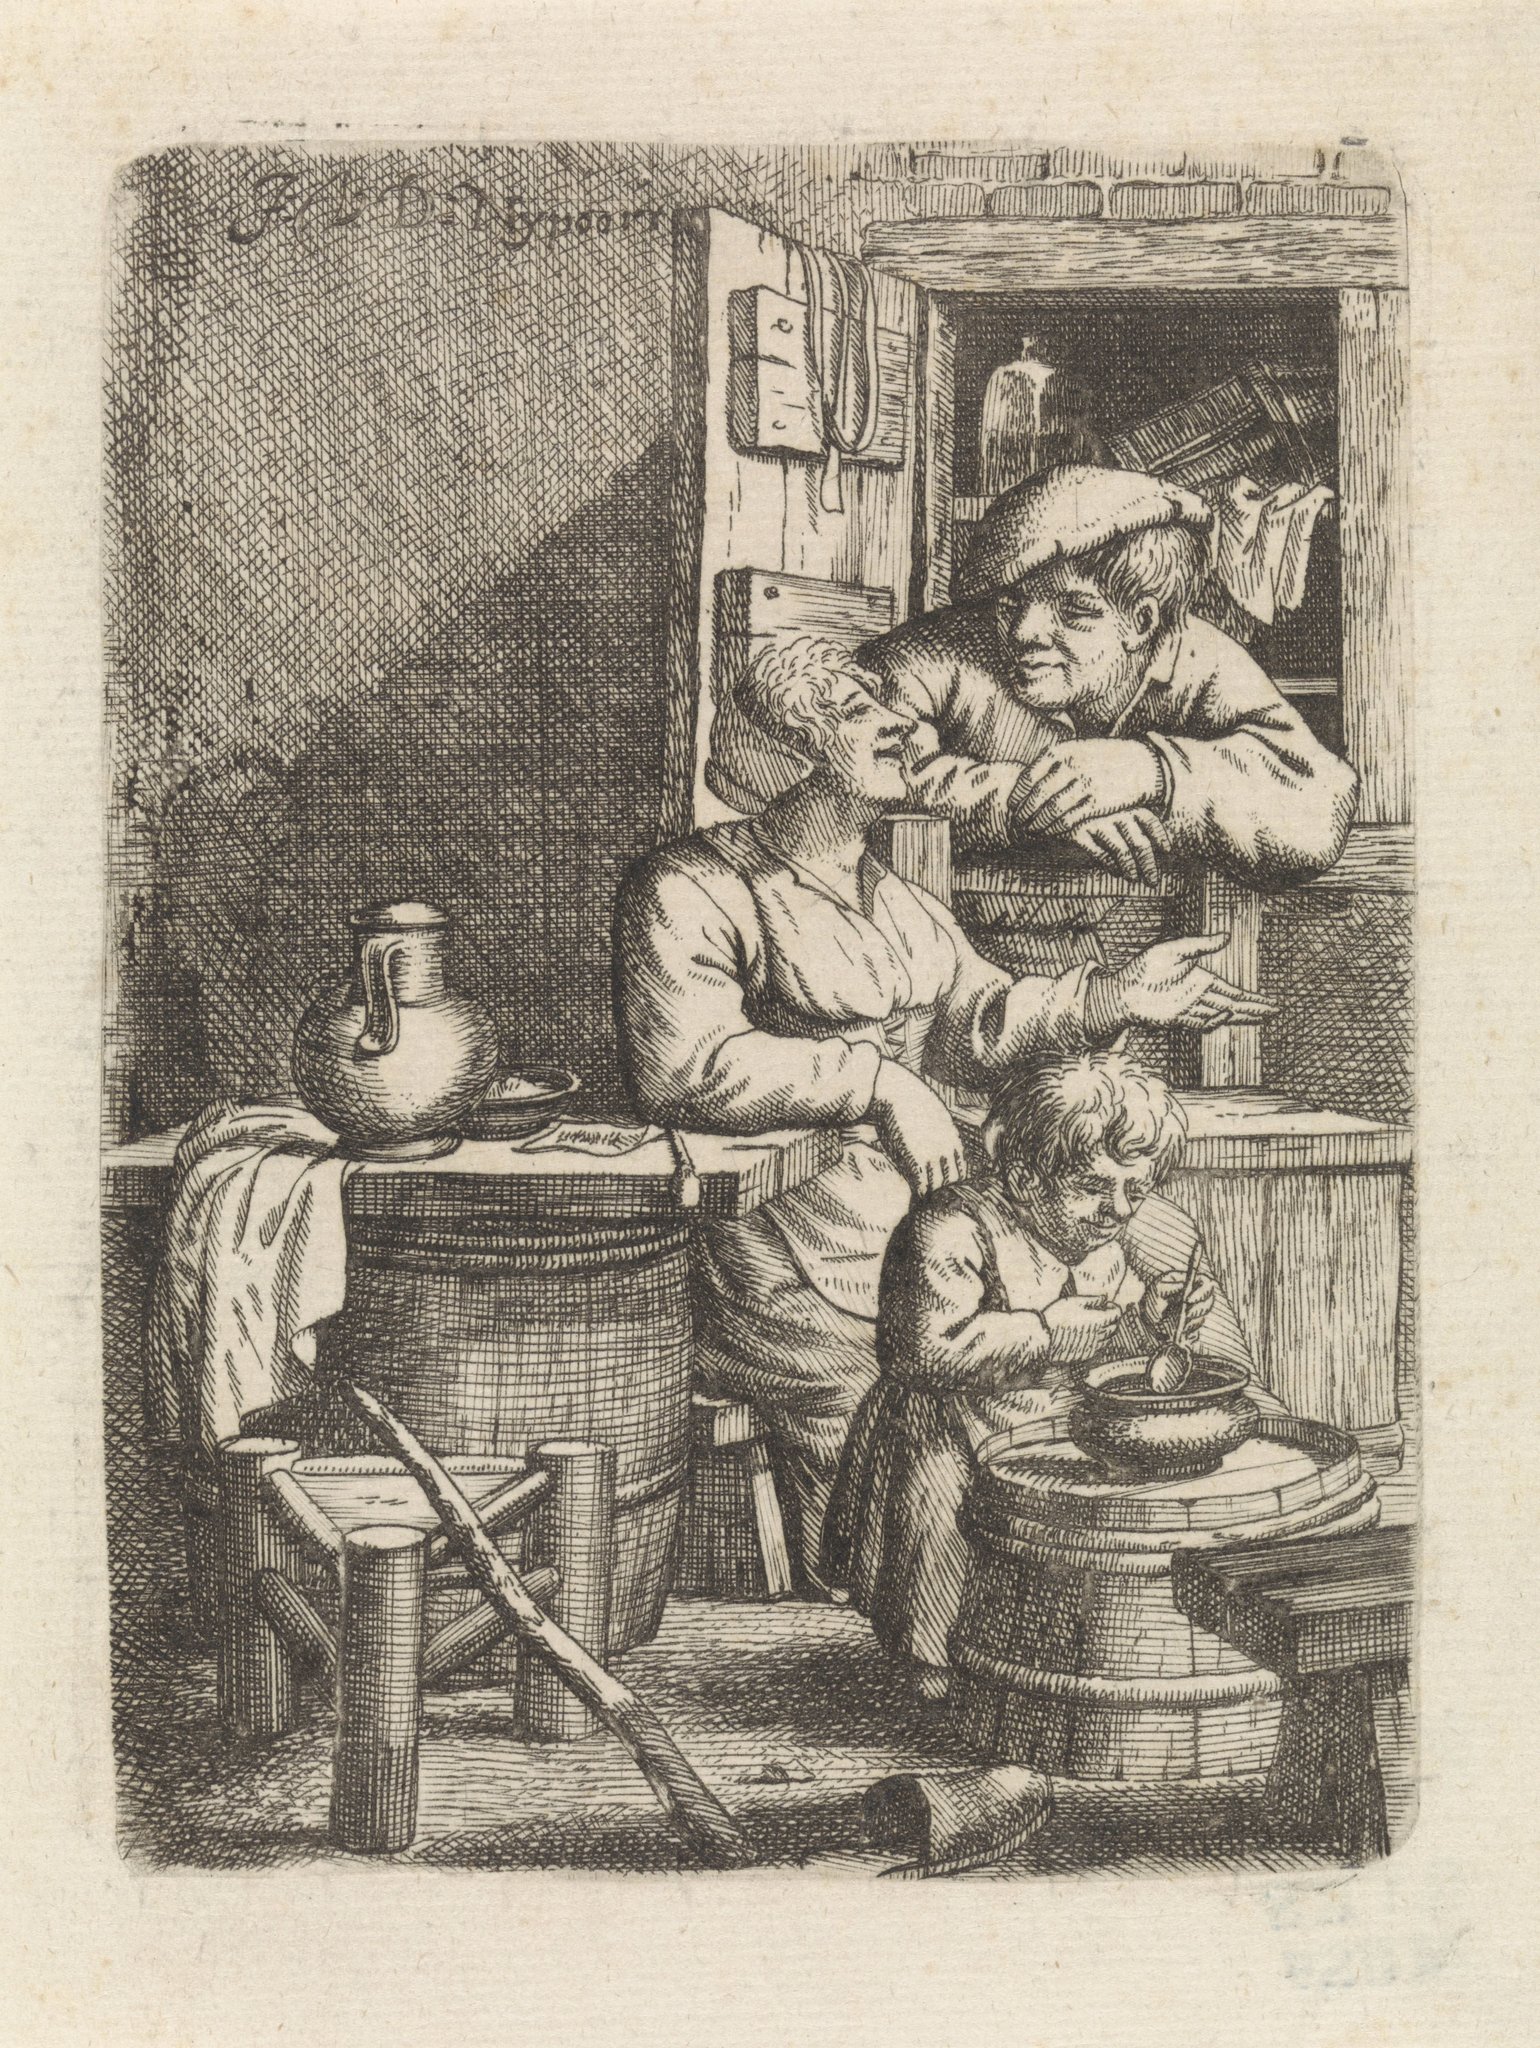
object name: print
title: Etend kind en een vrouw die met een man aan een raam praat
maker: justus van den nijpoort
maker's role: draughtsman, print maker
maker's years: 1625-1692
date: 1635-1692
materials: paper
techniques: engraving, etching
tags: human figure at (open) window, speaking, spoon, child (at home)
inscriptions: collector's mark: Lugt 2165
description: In het interieur van een boerenwoning staat een kind te eten uit een kom. Achter hem zit een vrouw, die met een man praat. De man staat aan de andere zijde van het geopende raam.